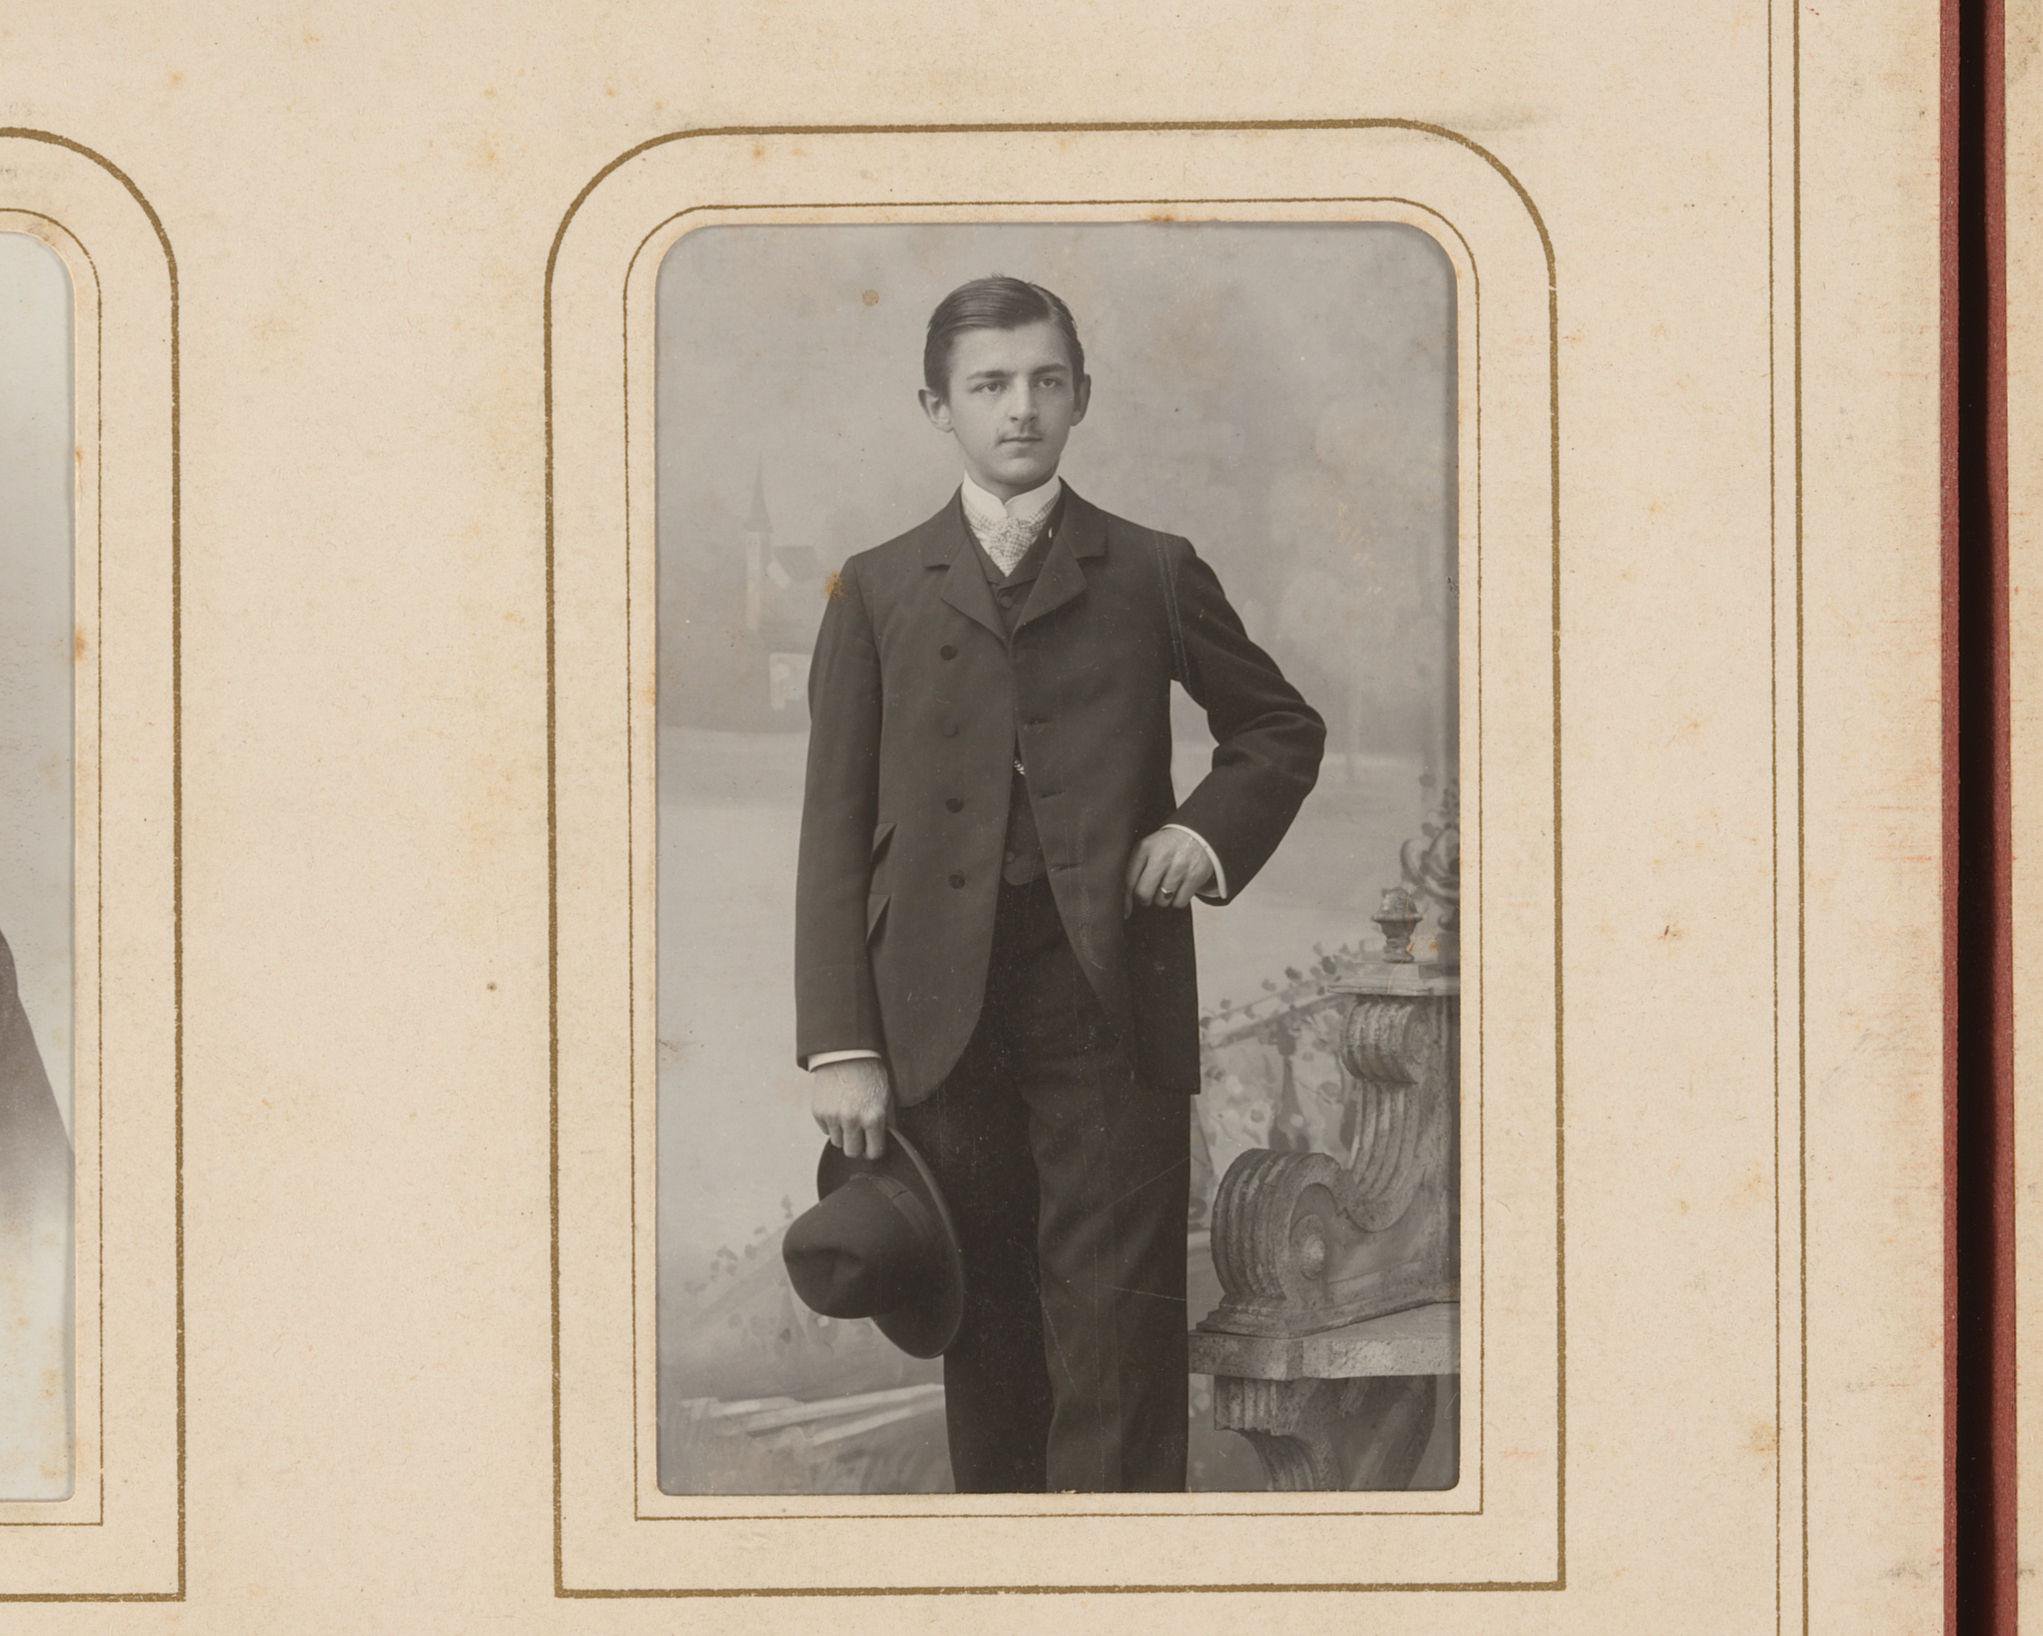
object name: album leaf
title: Portret van een jonge man met hoed in de hand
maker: louis frohwein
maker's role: fotograaf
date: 1895-1920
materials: cardboard, photographic support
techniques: matte daylight collodion silver print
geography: straatsburg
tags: historical persons, youth, adolescent, head-gear: hat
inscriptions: number: ‘12656/ [.] 4’